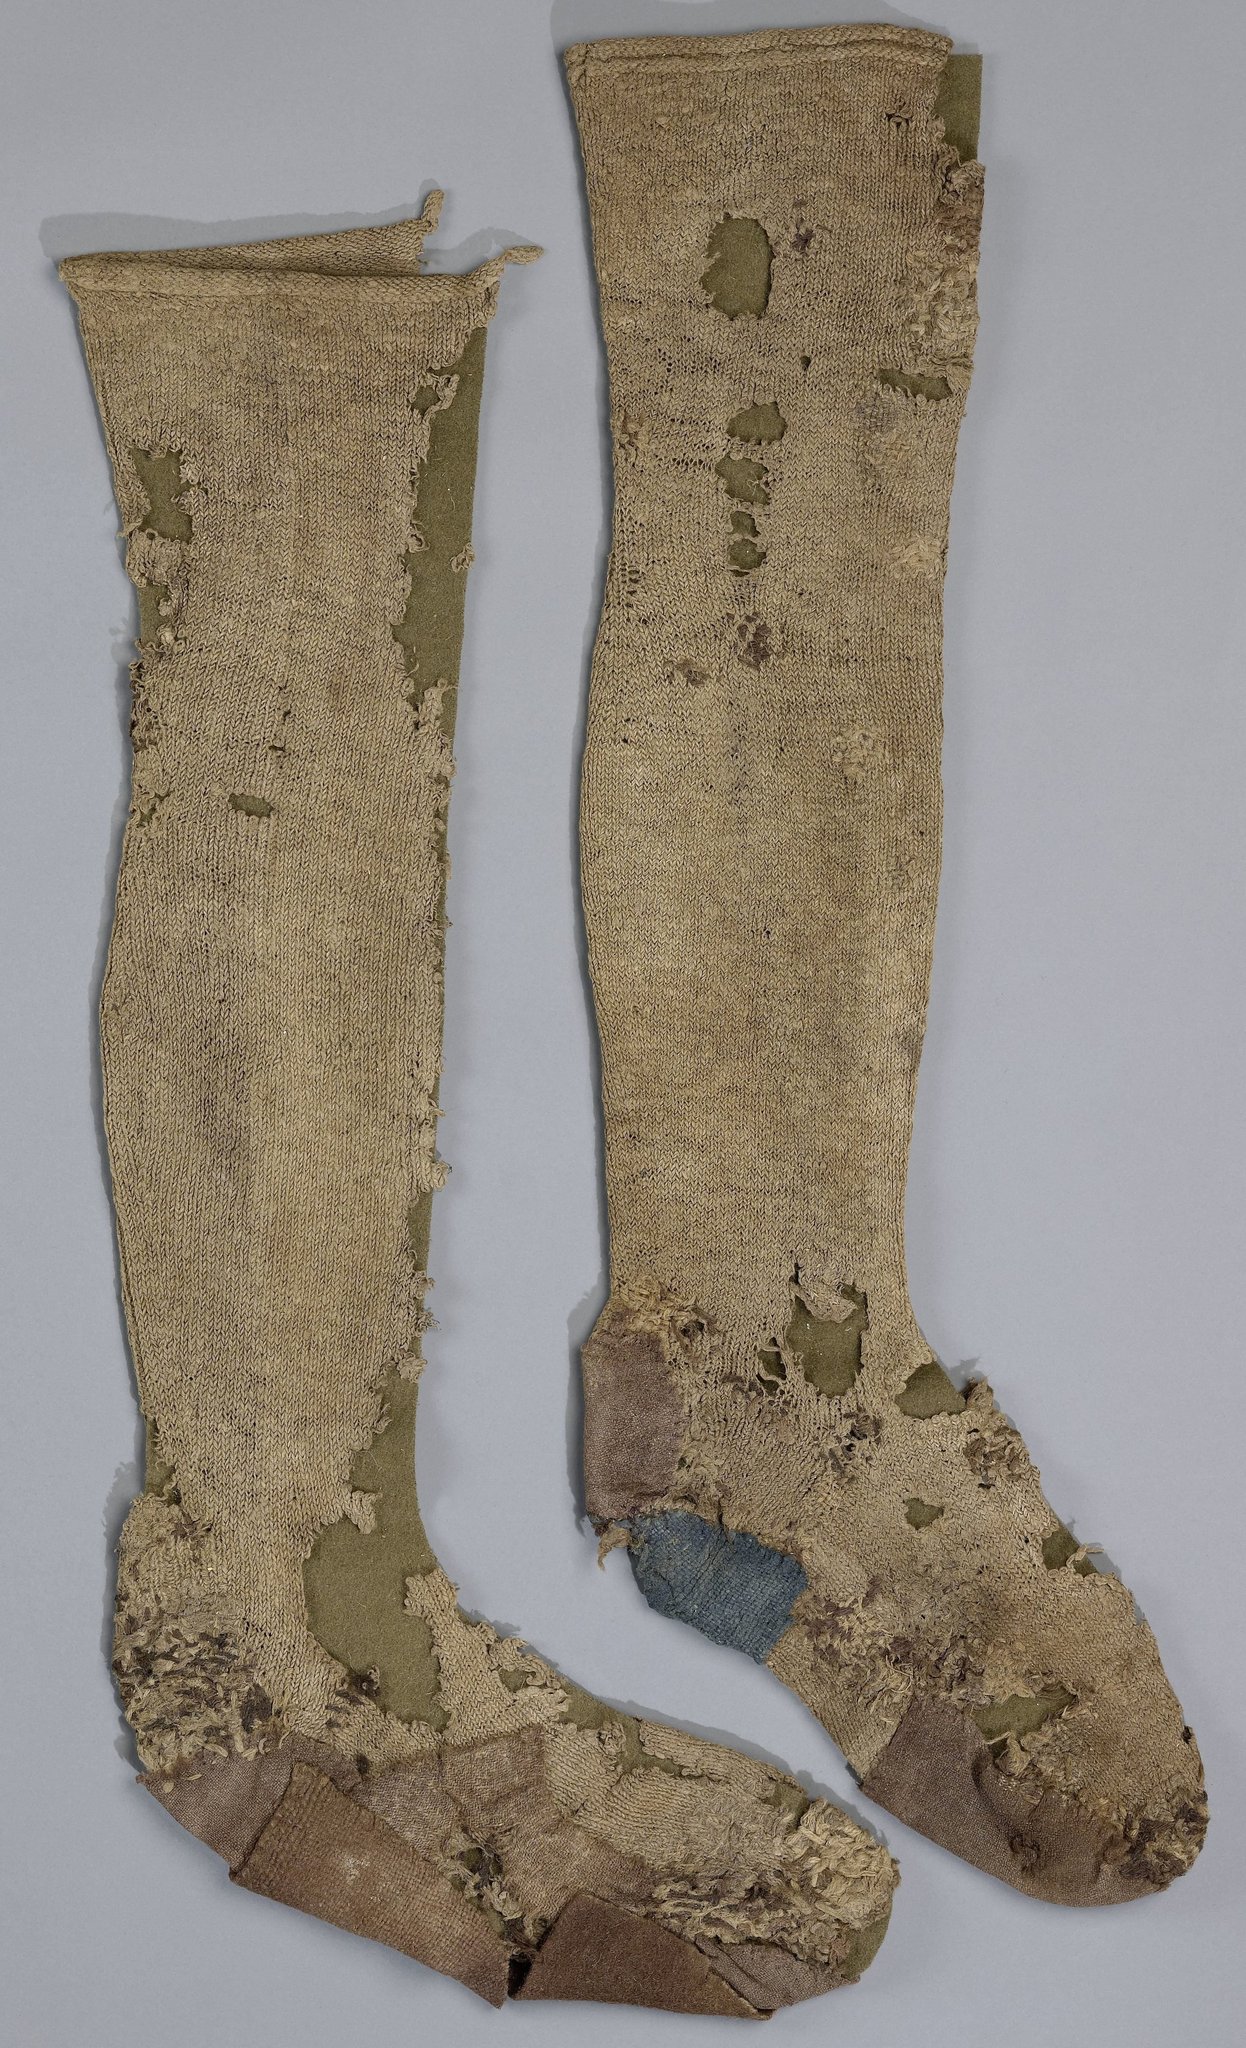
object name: kniekous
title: Kniekous, lichtbruin, de boord bestaat uit twee kleine stroken gebreid in averechte steek, zonder siernaad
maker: Anonymous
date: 1650-1700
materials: wool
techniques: knitting, weave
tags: noordse compagnie, spitsbergen, zeeuwsche uytkyck, svalbard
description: Kniekous, lichtbruin, de boord bestaat uit twee kleine stroken gebreid in averechte steek. Geen siernaad. Middelfijn met de hand rondgebreid in tricot-steek. Ook hier is geprobeerd de gaten te stoppen en is men er toe over gegaan tot het bevestigen van reparatiestukken, drie in getal. Alledrie in effen/plat binding geweven. Twee stukken zijn roodbruin en één blauw van kleur. Vormt gezien de verschillen geen paar met NG-2006-110-18-A.